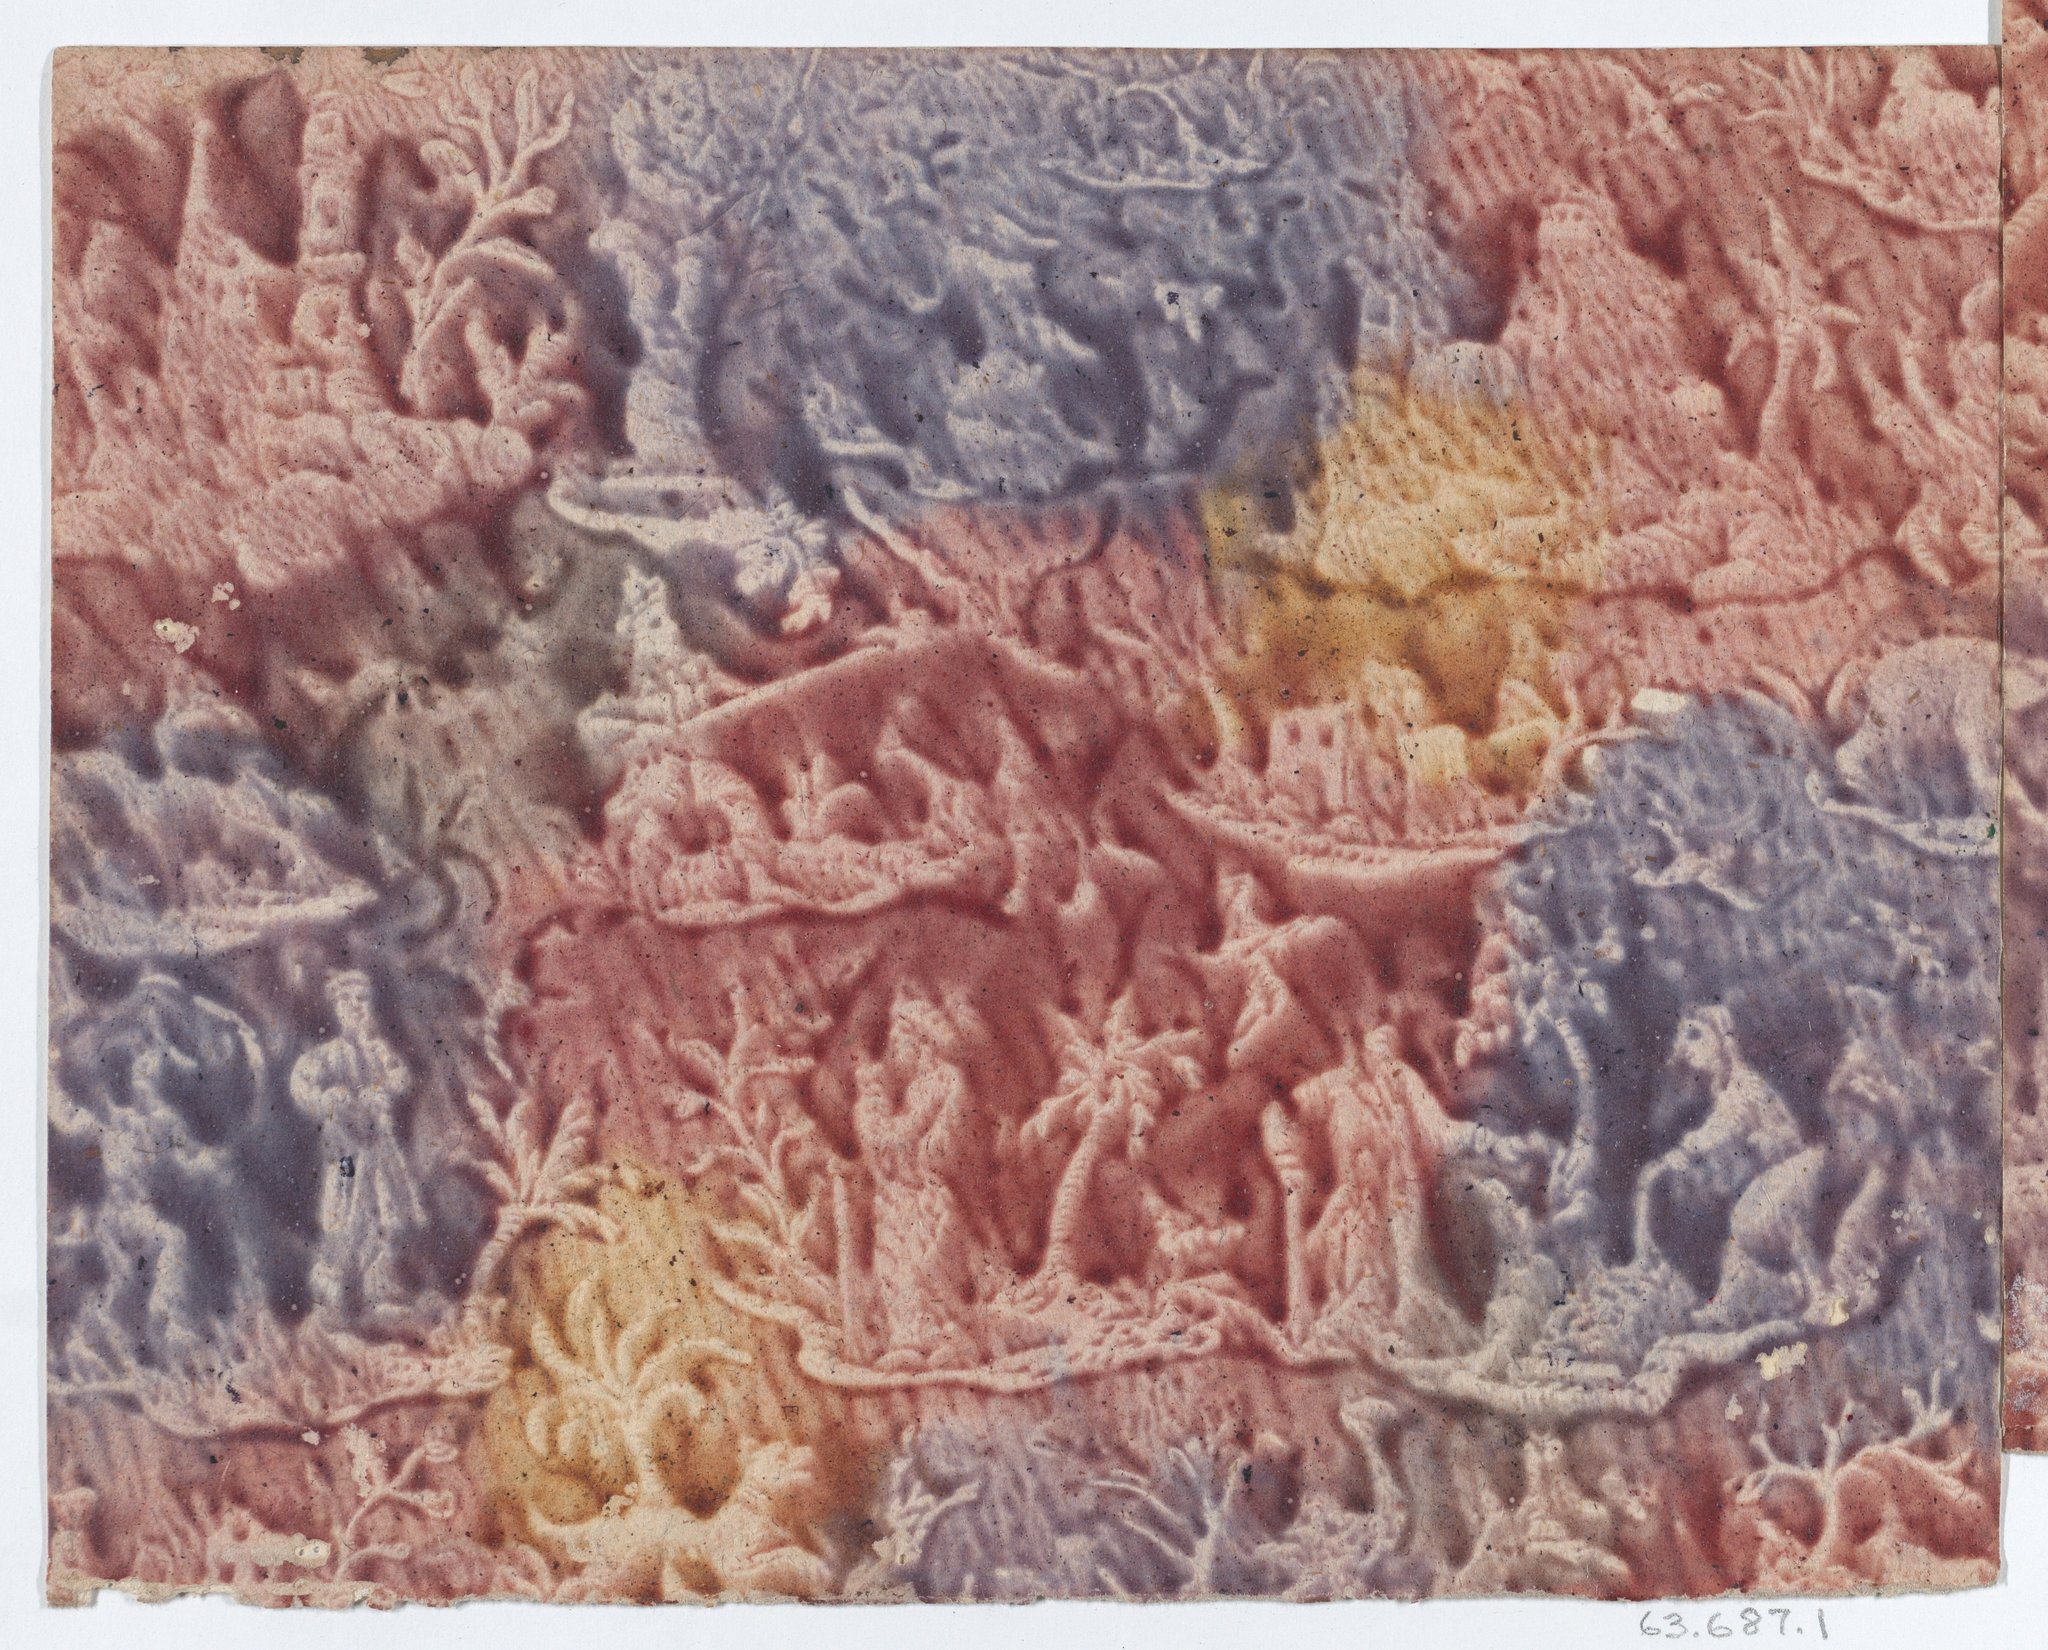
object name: print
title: Sheet with figures in landscapes in red, purple, and yellow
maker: Anonymous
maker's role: artist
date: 1701-1800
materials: paper, paste